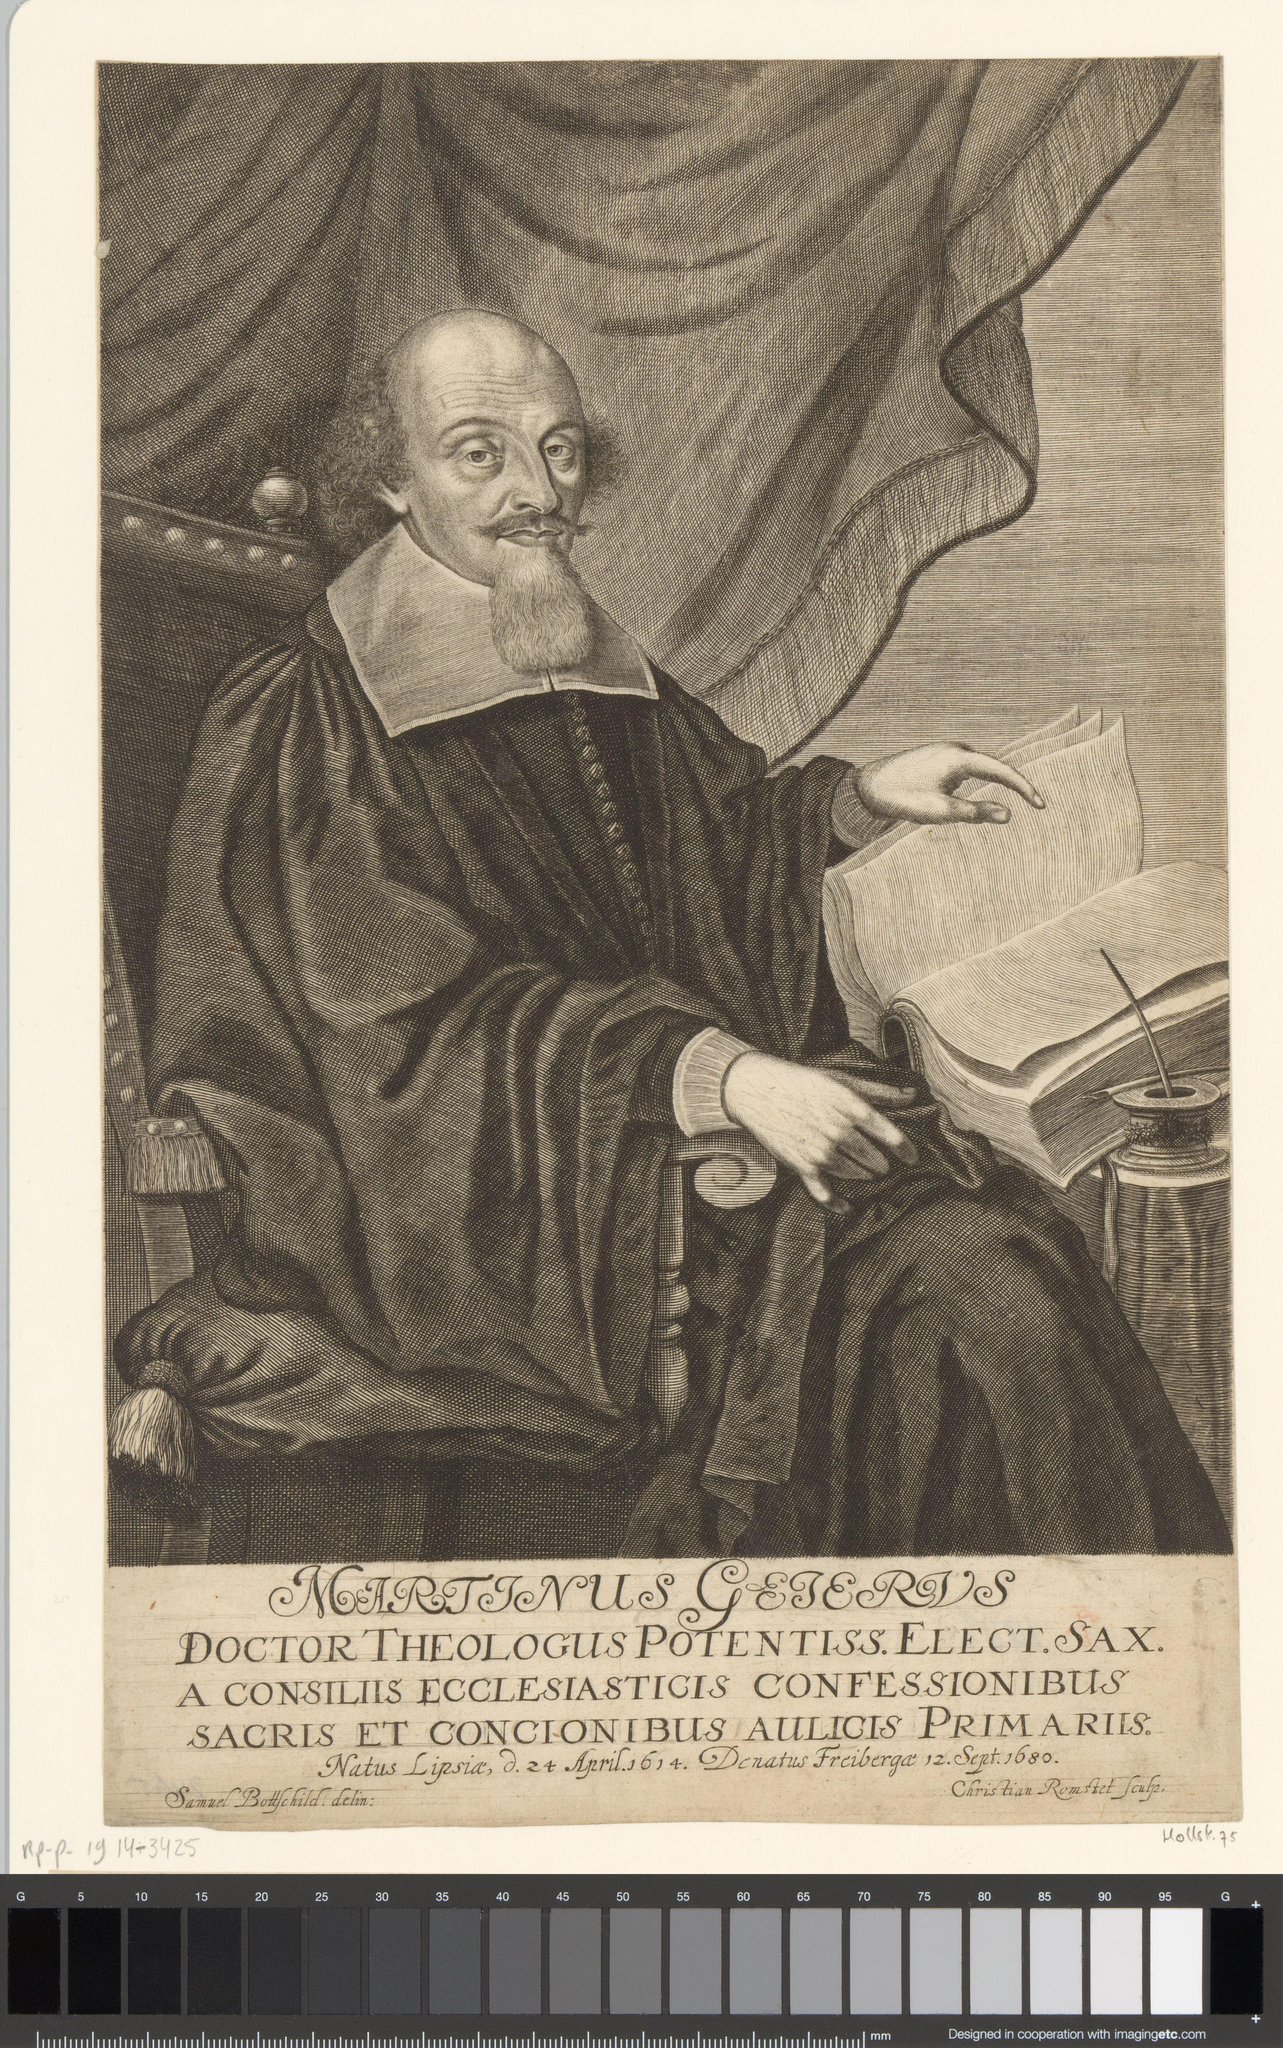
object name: print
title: Portret van Martin Geier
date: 1680-1721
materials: paper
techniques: engraving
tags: historical persons, writing accessories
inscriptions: collector's mark: Lugt 2228